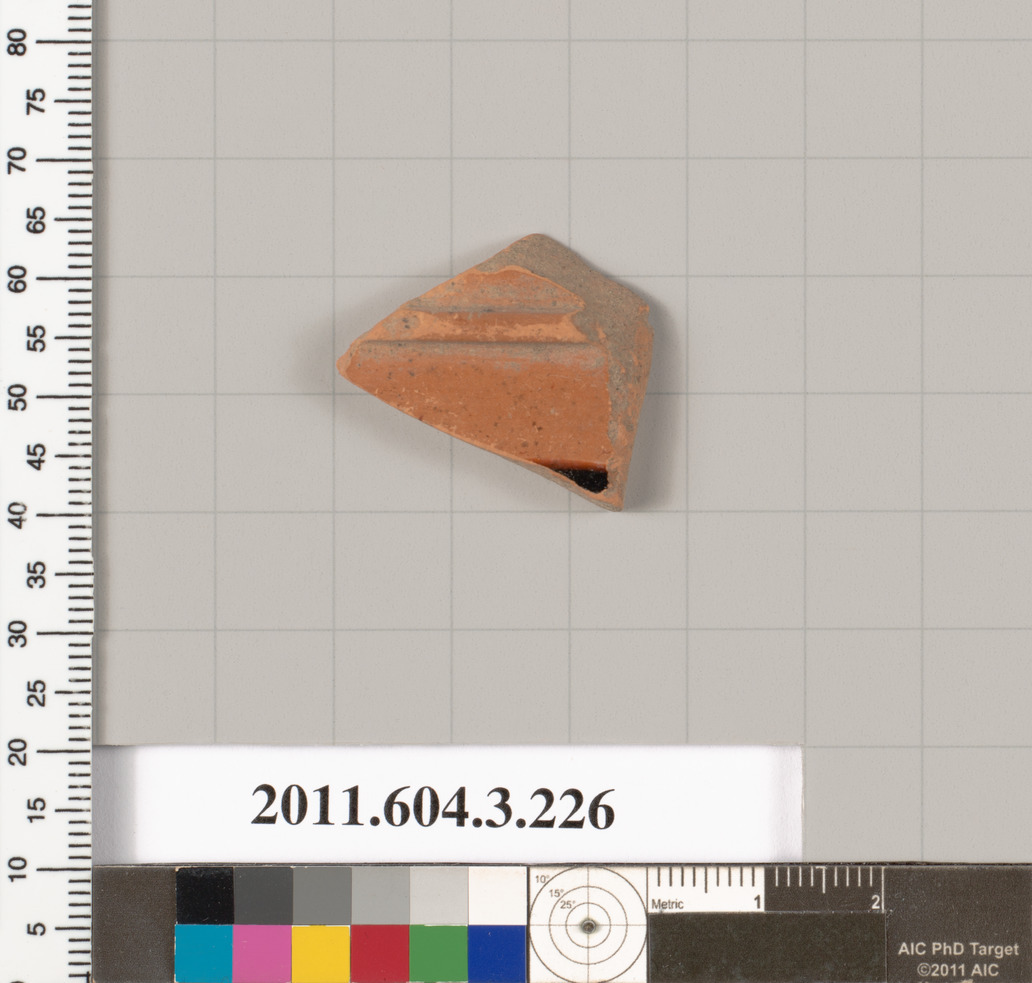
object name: neck amphora fragment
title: Terracotta fragment of a neck-amphora of Nicosthenic shape (jar)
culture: greek, attic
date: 525-501 BCE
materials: terracotta